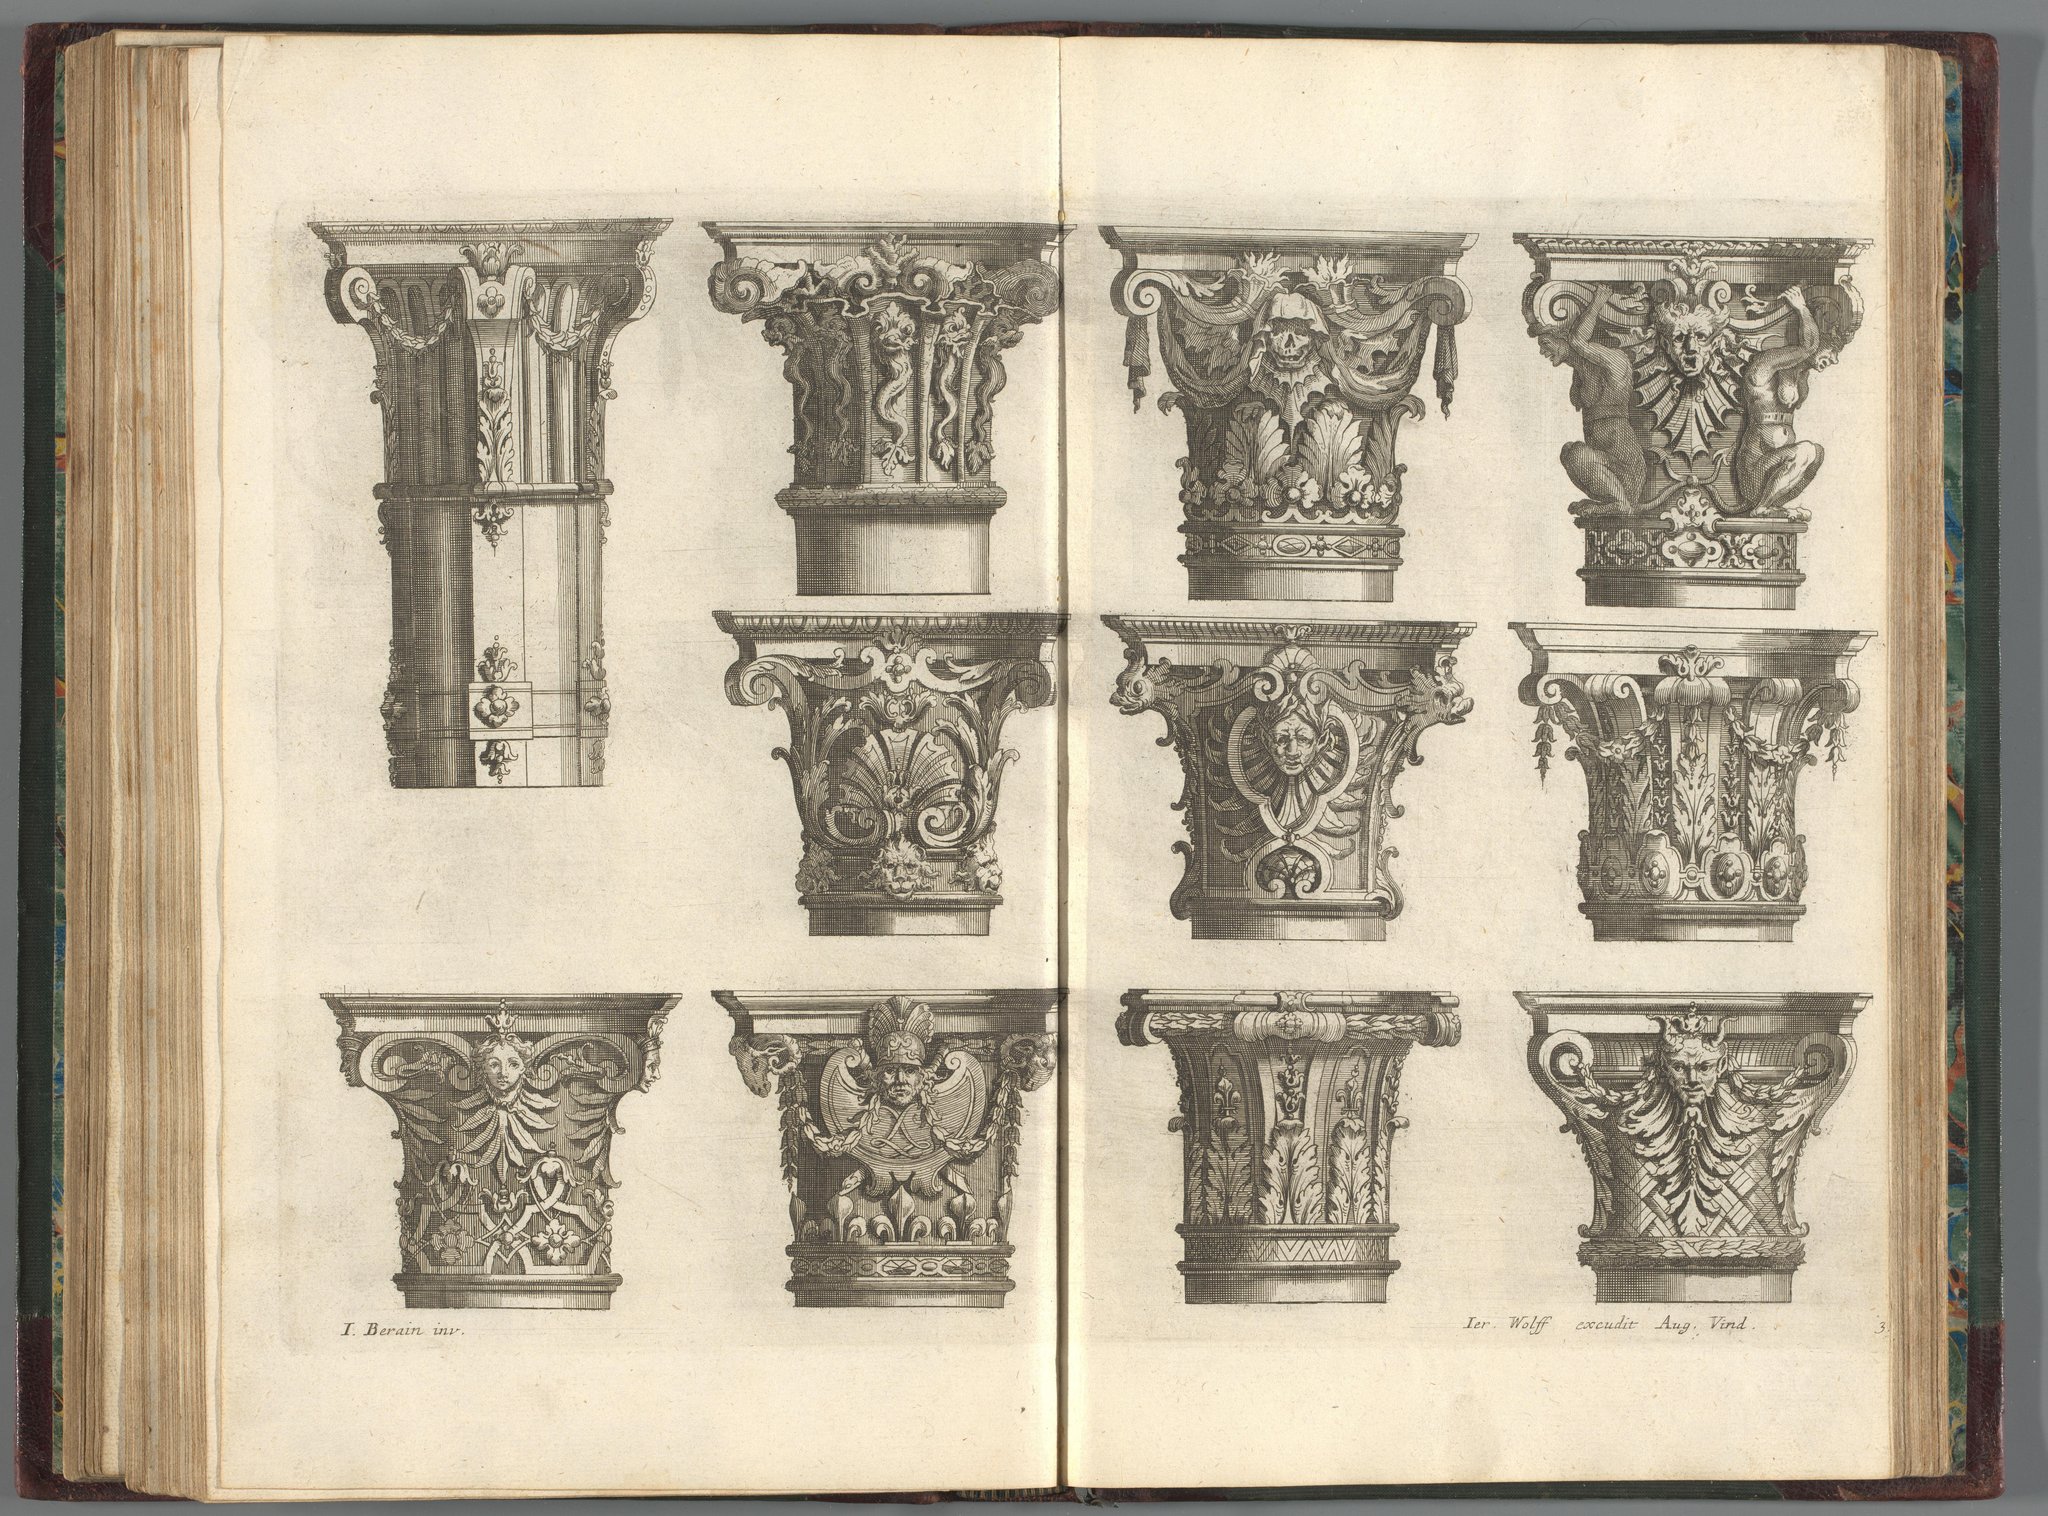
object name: album leaf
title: Ontwerpen van kapitelen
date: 1686-1724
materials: paper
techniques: etching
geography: augsburg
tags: ornaments ~ art, capital (~ column, pillar)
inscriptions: number: ‘3’, signature: ‘I. Berain inv.’, signature: ‘Ier. Wolff excudit Aug. Vind.’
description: Elf ontwerpen van kapitelen, waarvan een met een deel van de zuil. Allemaal variërend versierd met maskers, florale motieven, kariatiden en een doodshoofd. Prent maakt deel uit van een album. Hoogstwaarschijnlijk gespiegelde kopie naar Frans origineel.